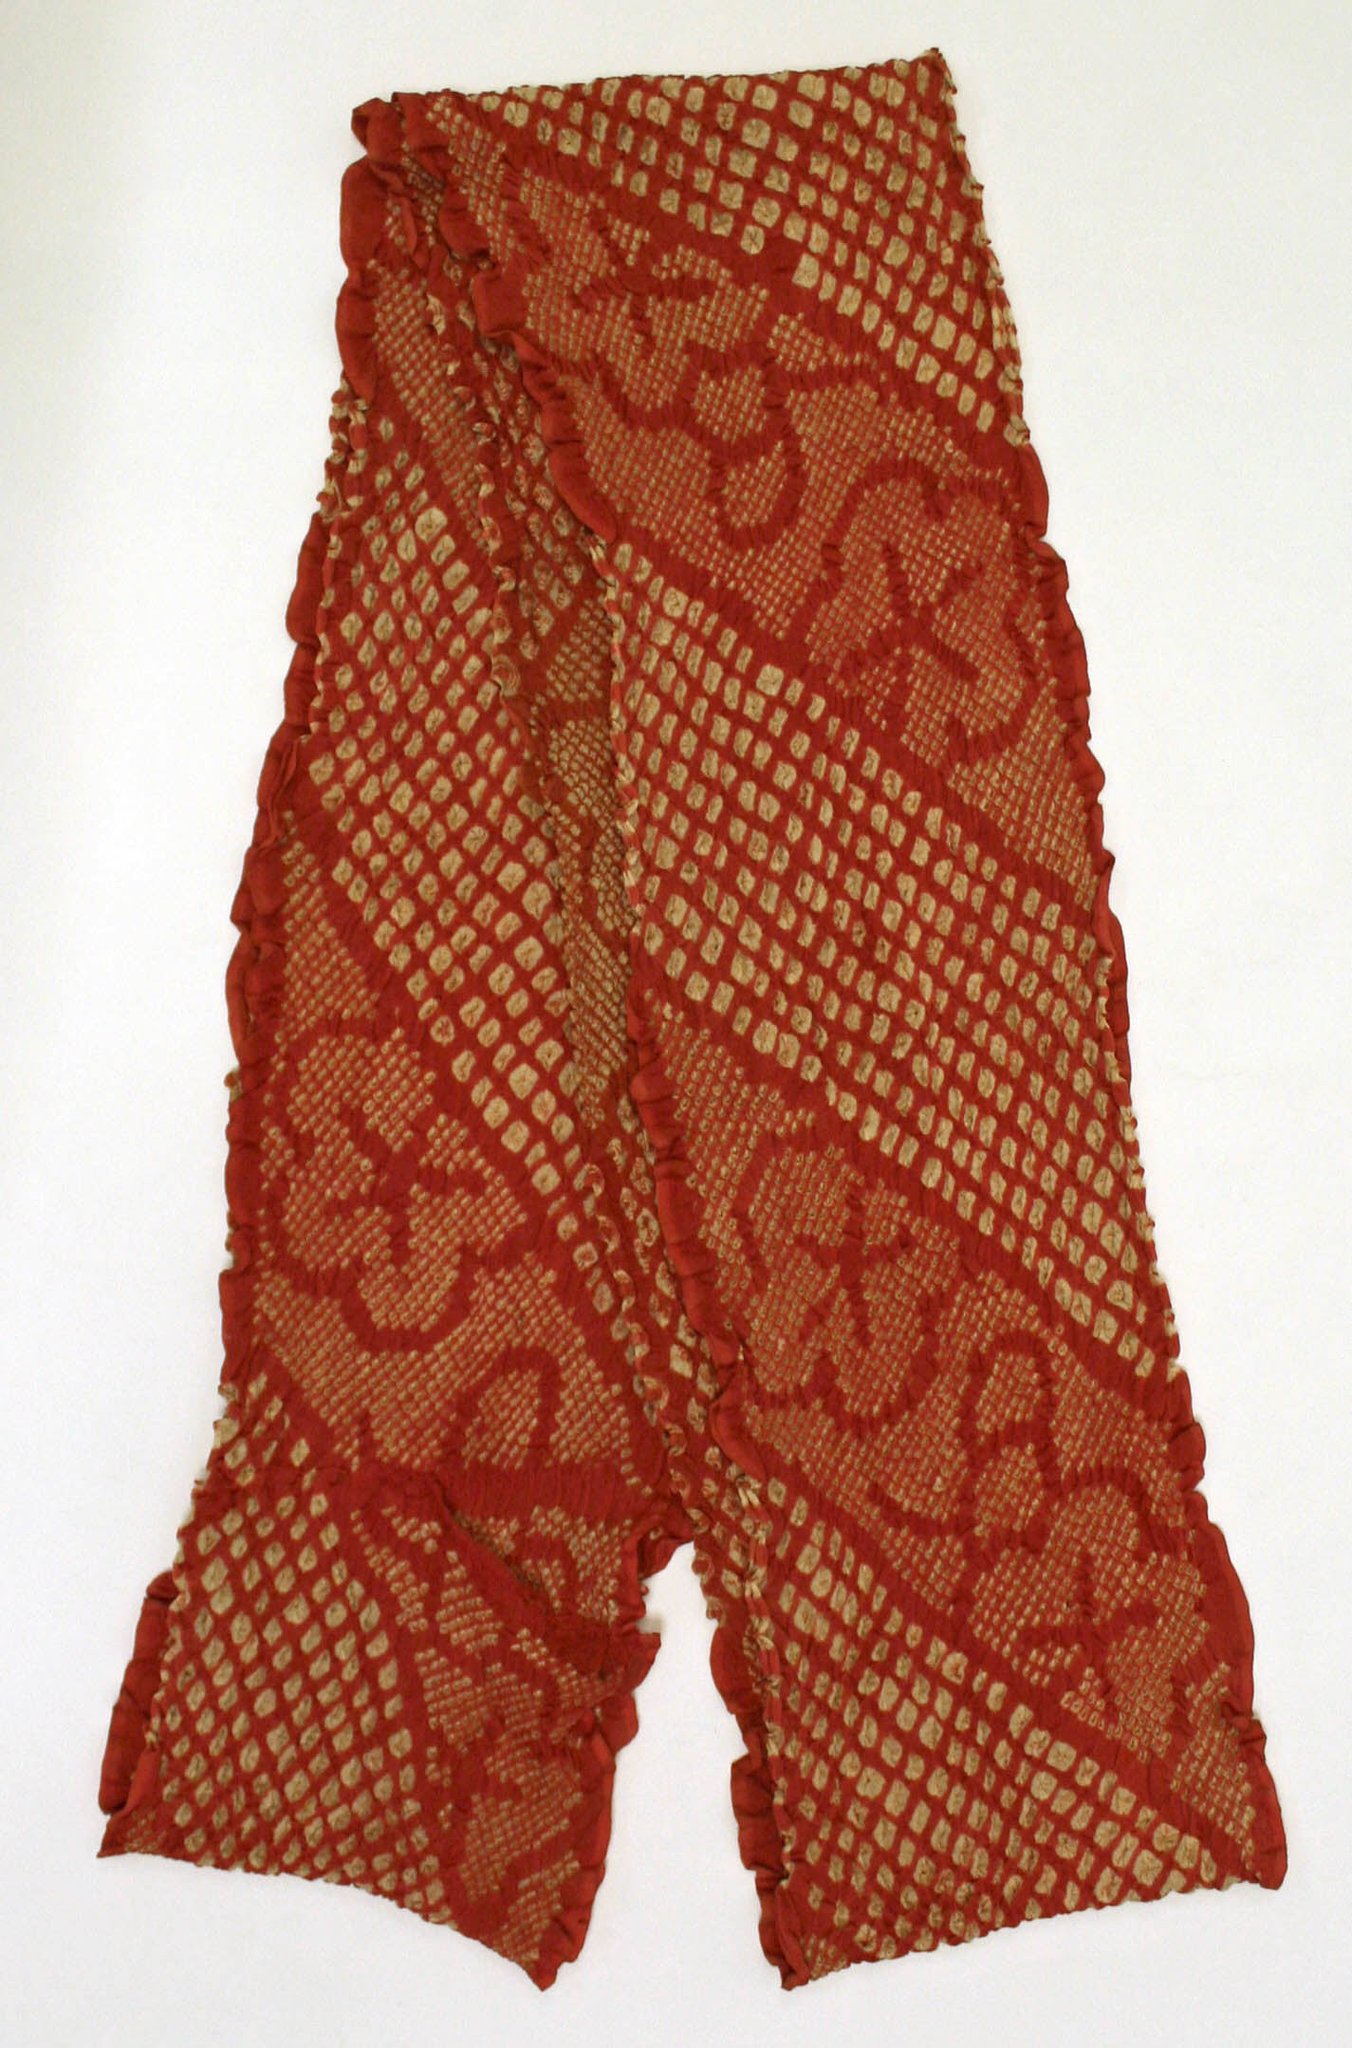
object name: sash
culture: japanese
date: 1800-1941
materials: silk